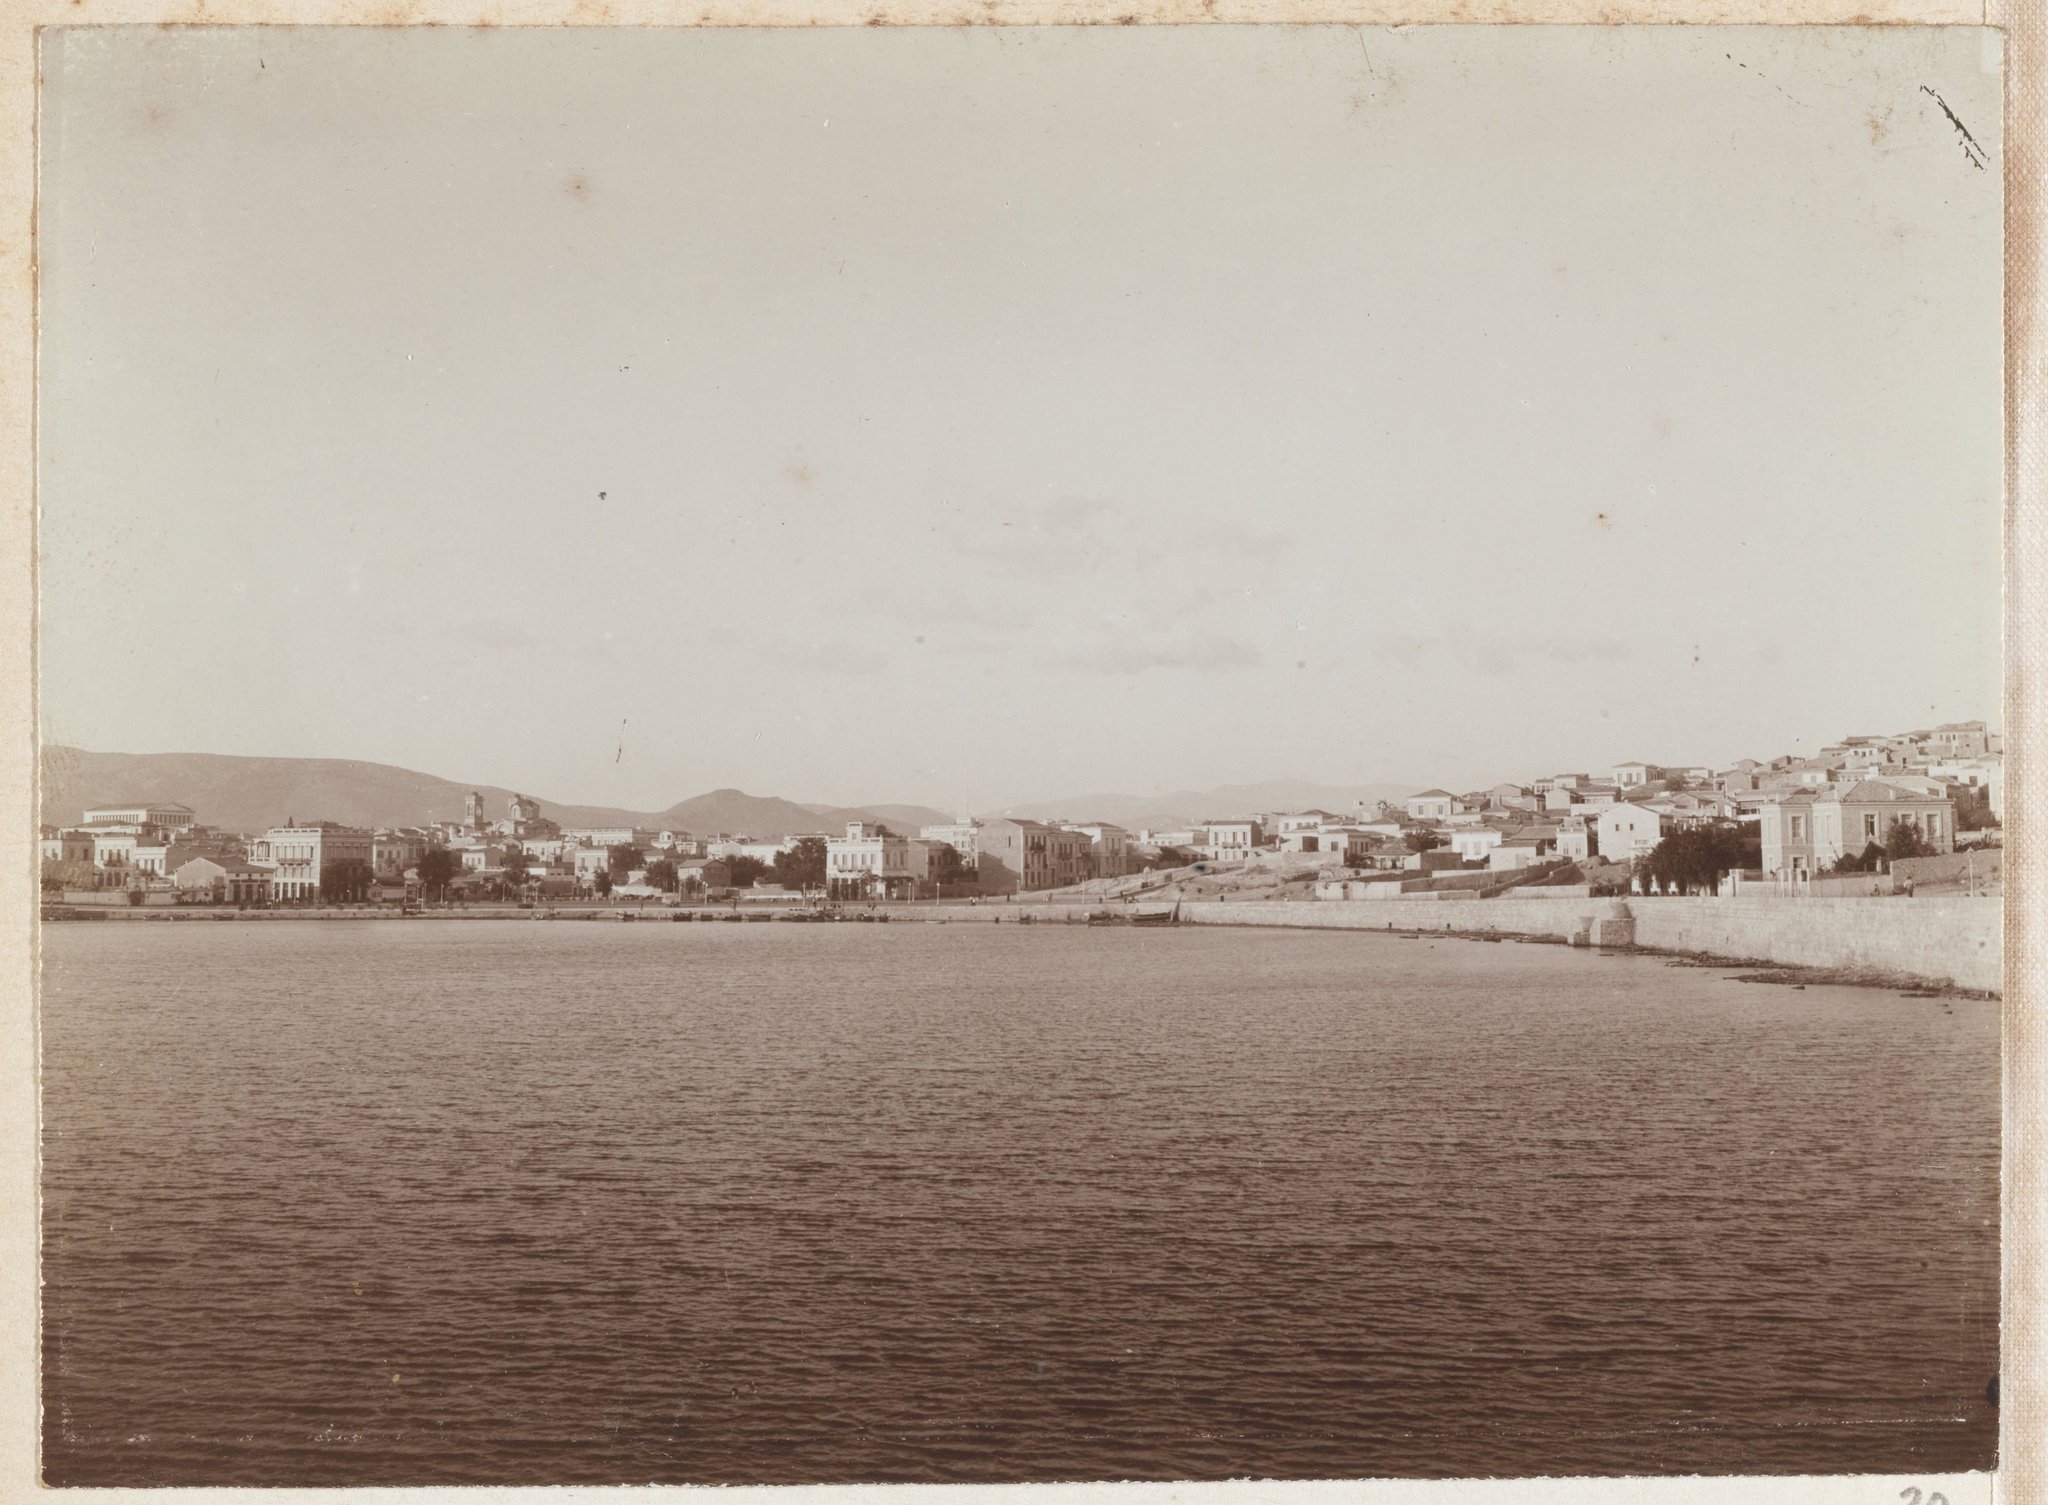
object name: page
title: Haven van Piraeus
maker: johannes lodewijk heldring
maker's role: fotograaf, predikant, schrijver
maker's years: 1852-1923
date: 1898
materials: paper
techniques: collodion silver print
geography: piraeus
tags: harbour